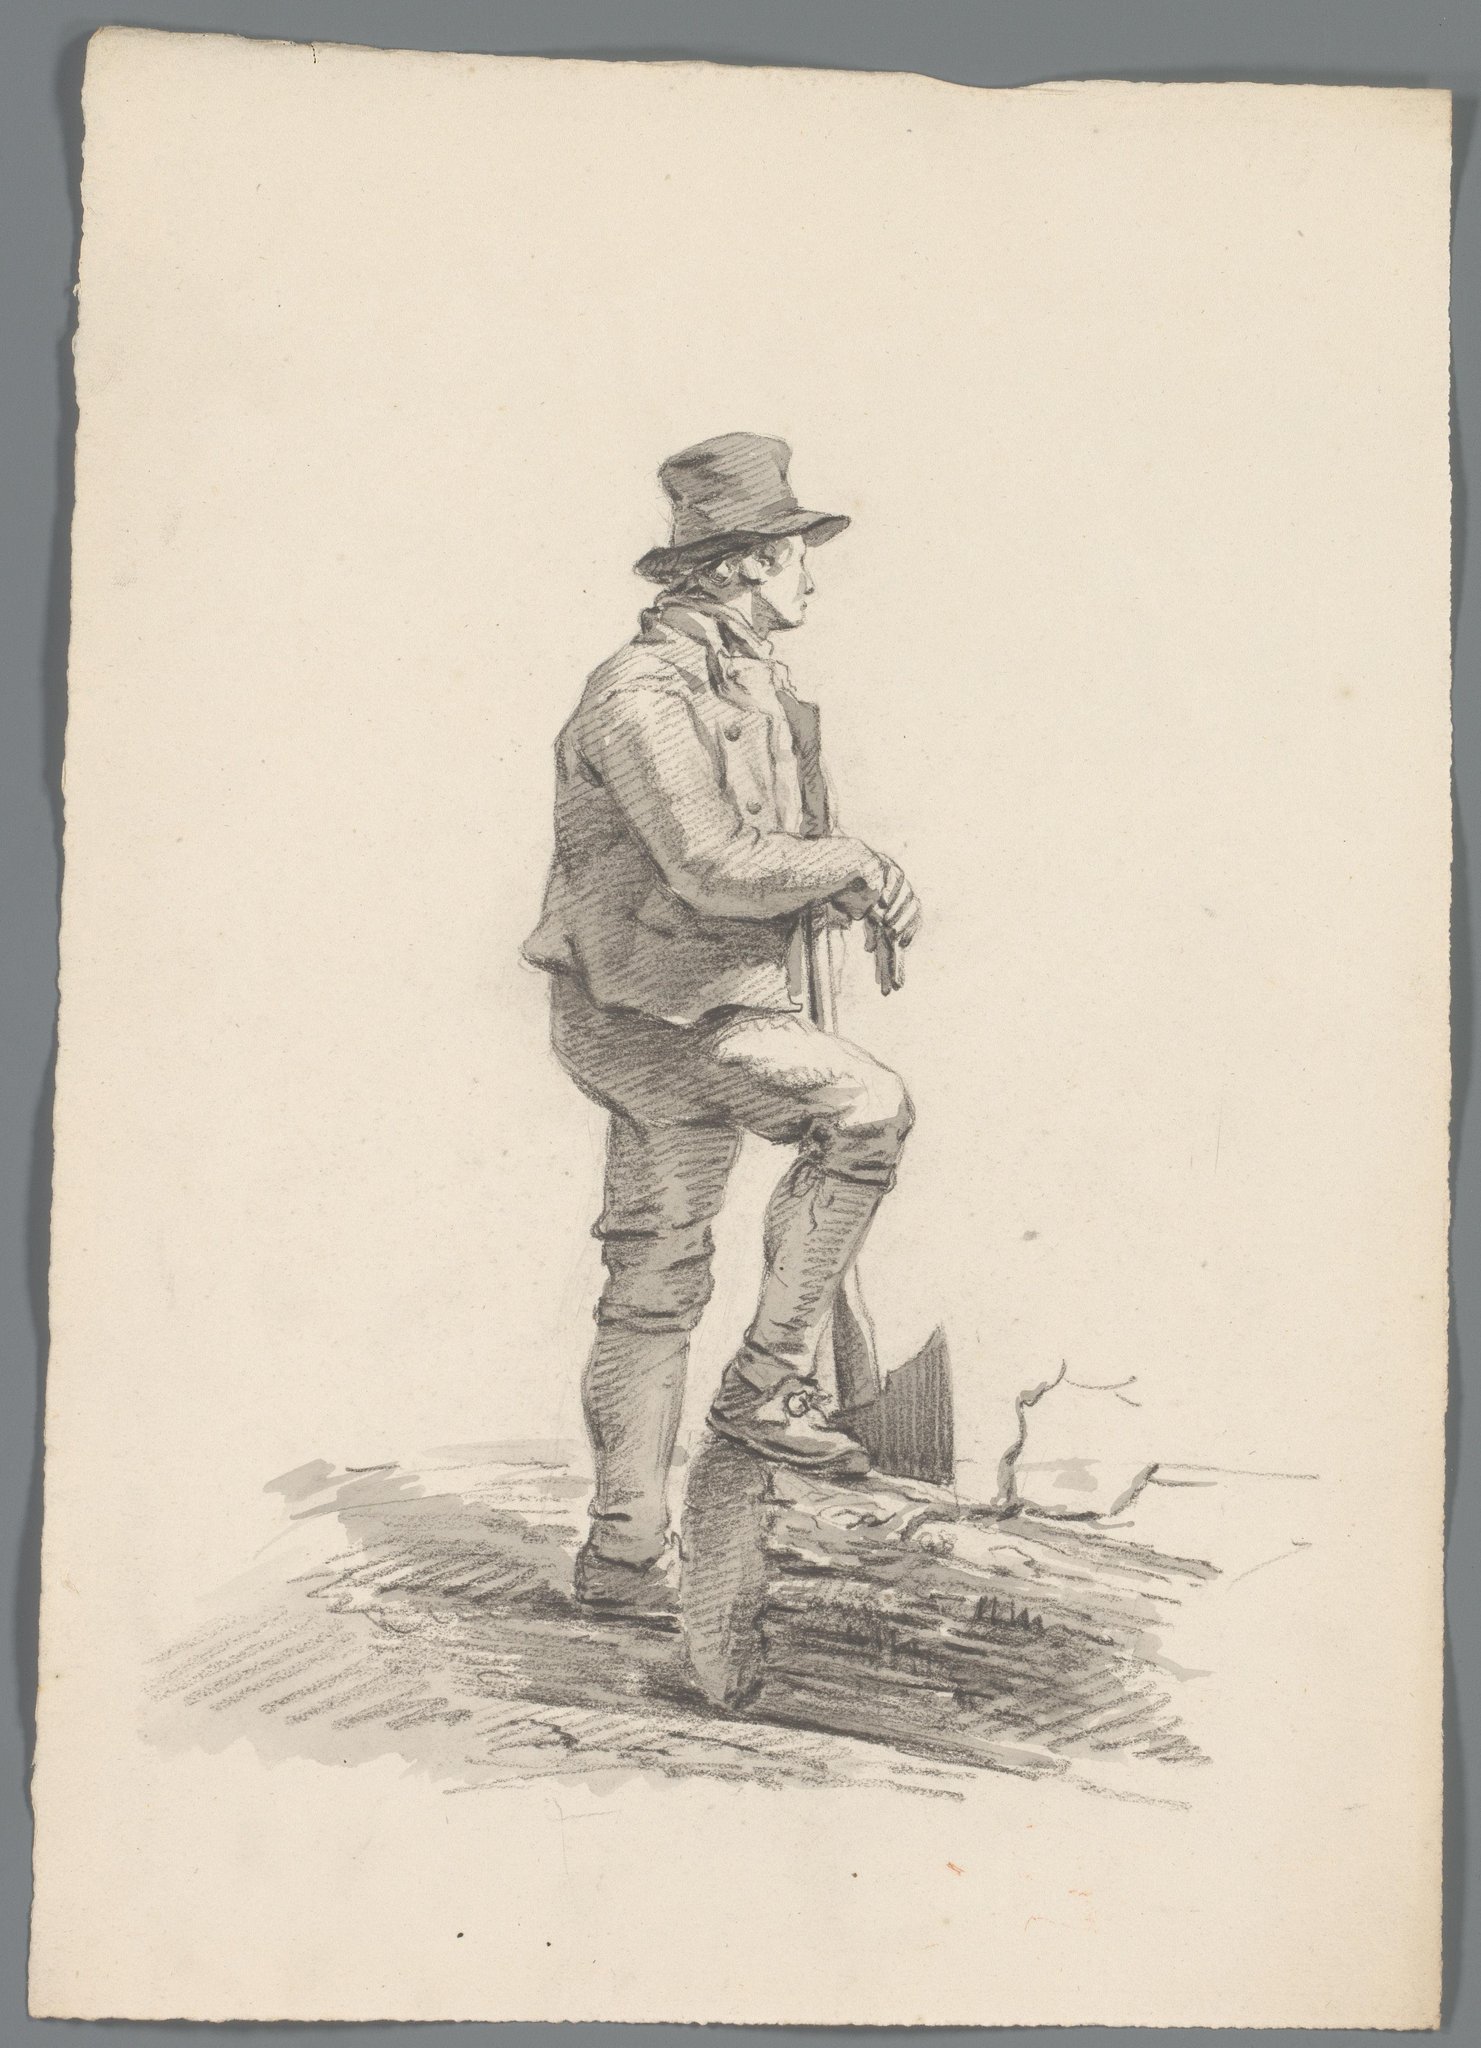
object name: drawing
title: Houthakker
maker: Anonymous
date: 1820-1830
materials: chalk, paper, watercolor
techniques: brush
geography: the hague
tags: woodcutting, woodcutter ~ forestry, adult man, tools, aids, implements ~ crafts and industries: axe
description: Tekeningen waarschijnlijk ontstaan bij het Haagse kunstgenootschap ‘Tot Nut der Tekenkunst’, waar twee keer per week tekenavonden werden georganiseerd met geklede modellen.